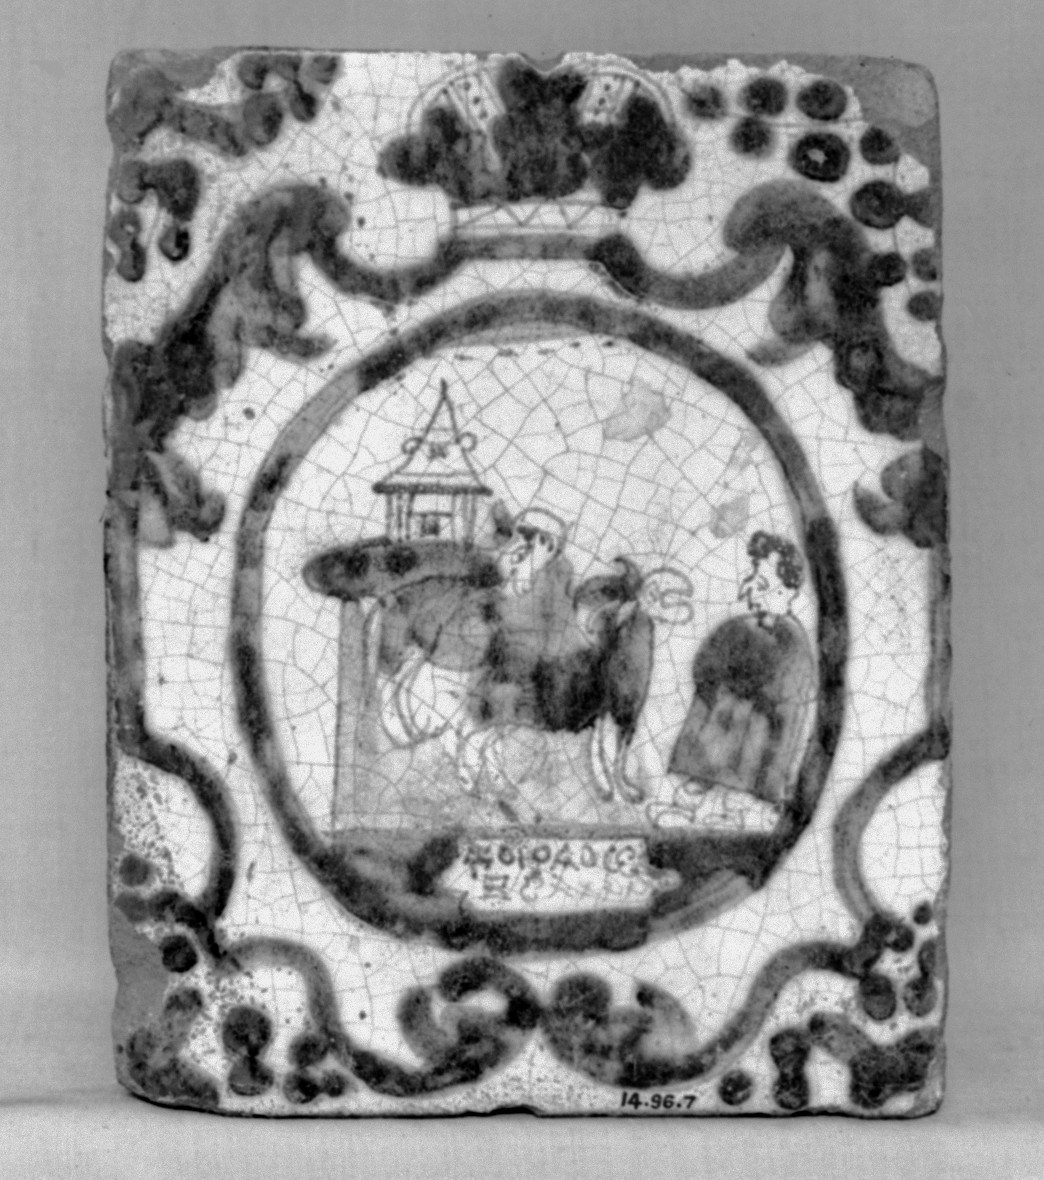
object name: stove tile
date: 1701-1800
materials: pottery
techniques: glazing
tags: animals,houses,men